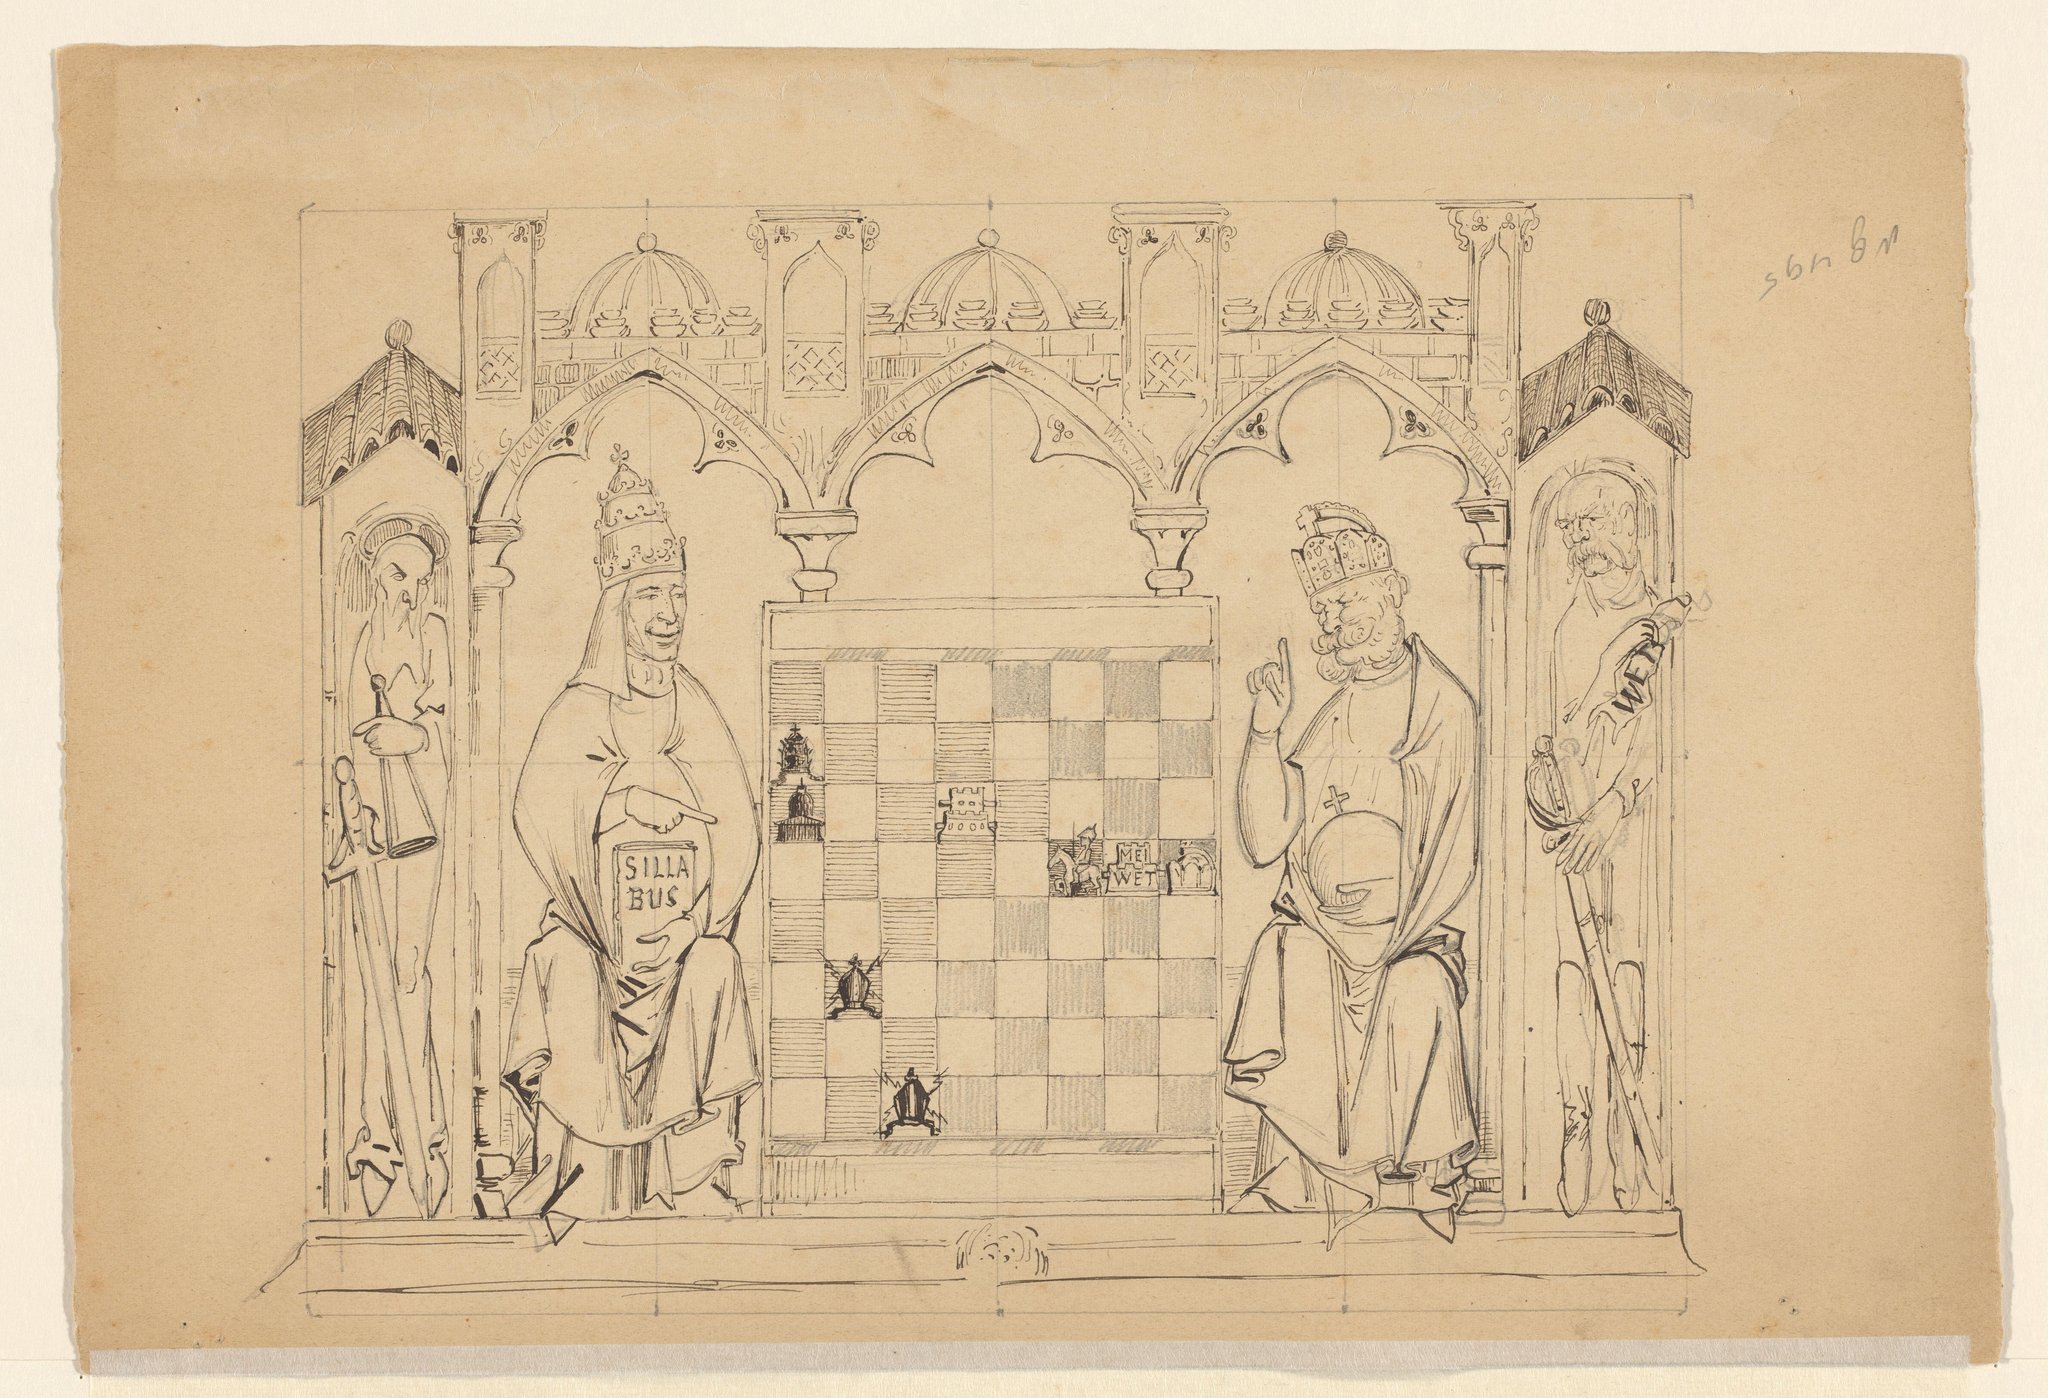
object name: cartoon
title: Studie voor spotprent op Bismarck en de paus, 1878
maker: johan michaël schmidt crans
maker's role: draughtsman, print maker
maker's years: 1830-1907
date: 1878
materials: ink, paper, pencil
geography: netherlands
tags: rome, leo xiii, political caricatures and satires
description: Schets voor de spotprent 'Hoog Spel' met Bismarck en paus Leo XIII in 1878. Beiden in vol ornaat gezeten aan weerszijden van een schaakbord, paus links met Sillabus in de linkerhand. Gezet in gotisch interieur. Schets voor een spotprent in De Nederlandsche Spectator van 1878, nr. 15.